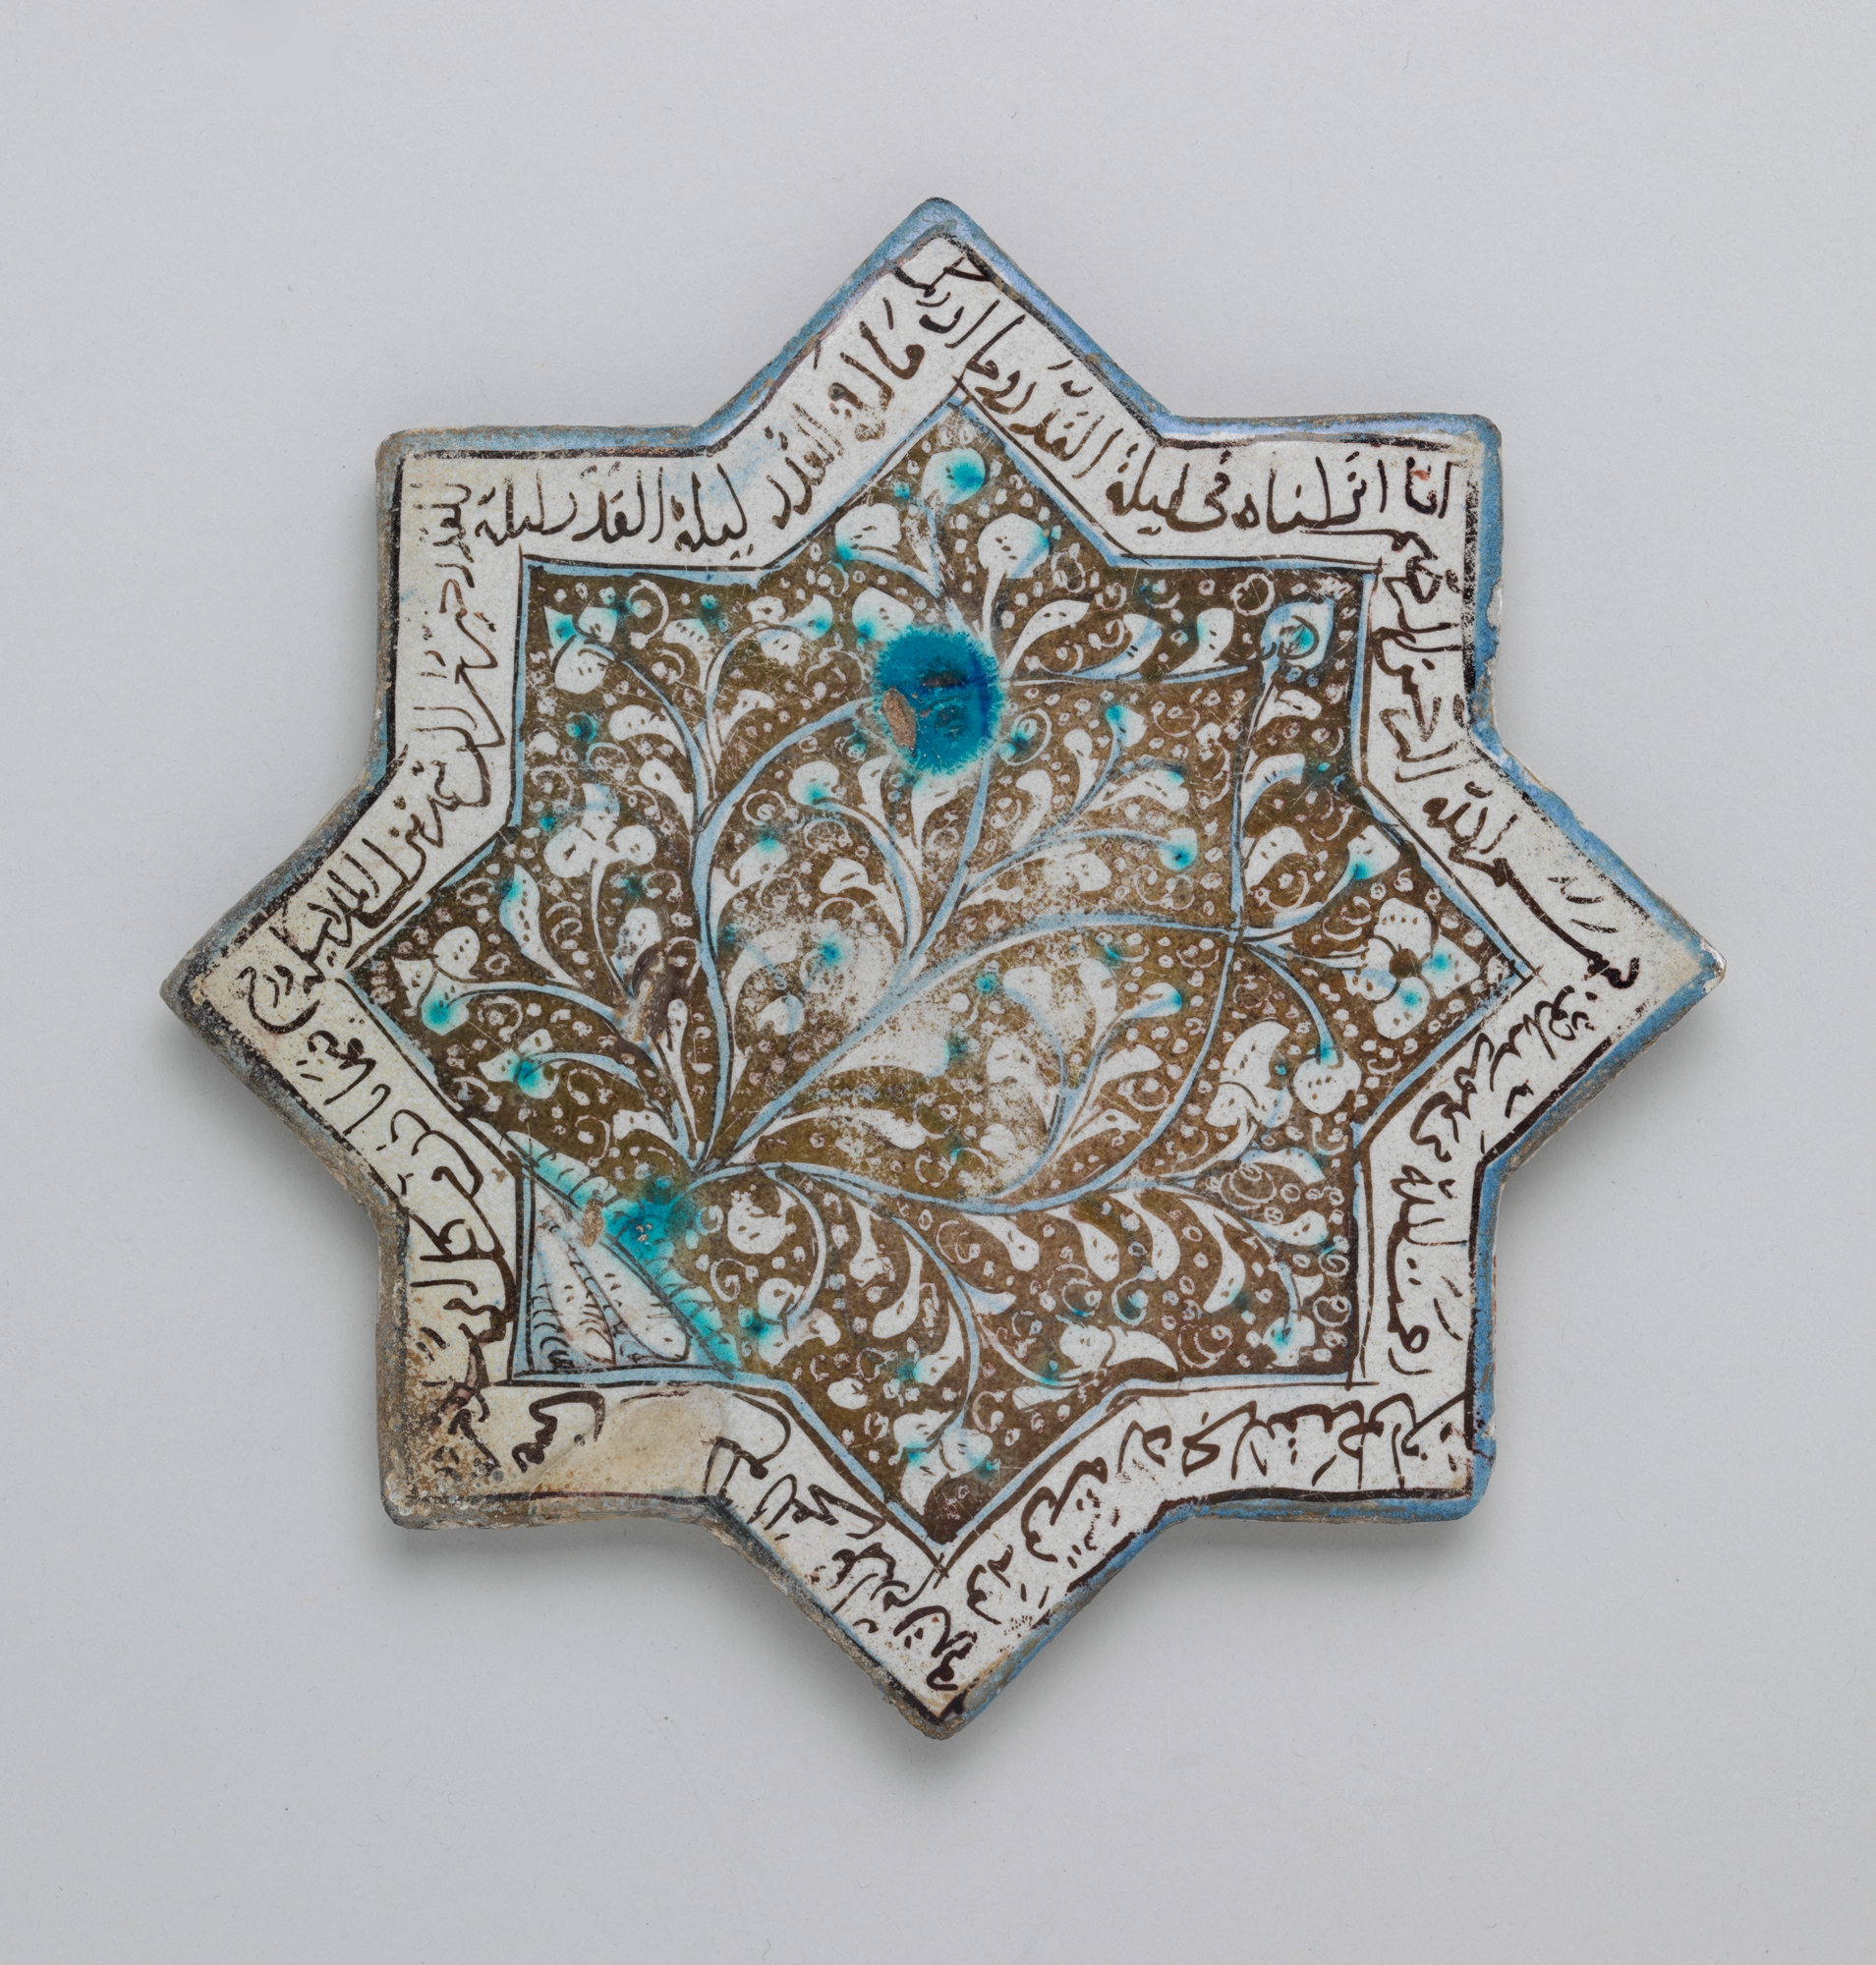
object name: tile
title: Eight-pointed Star Tile with Foliage and Inscription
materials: glaze, stonepaste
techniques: luster painting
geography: iran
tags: leaves